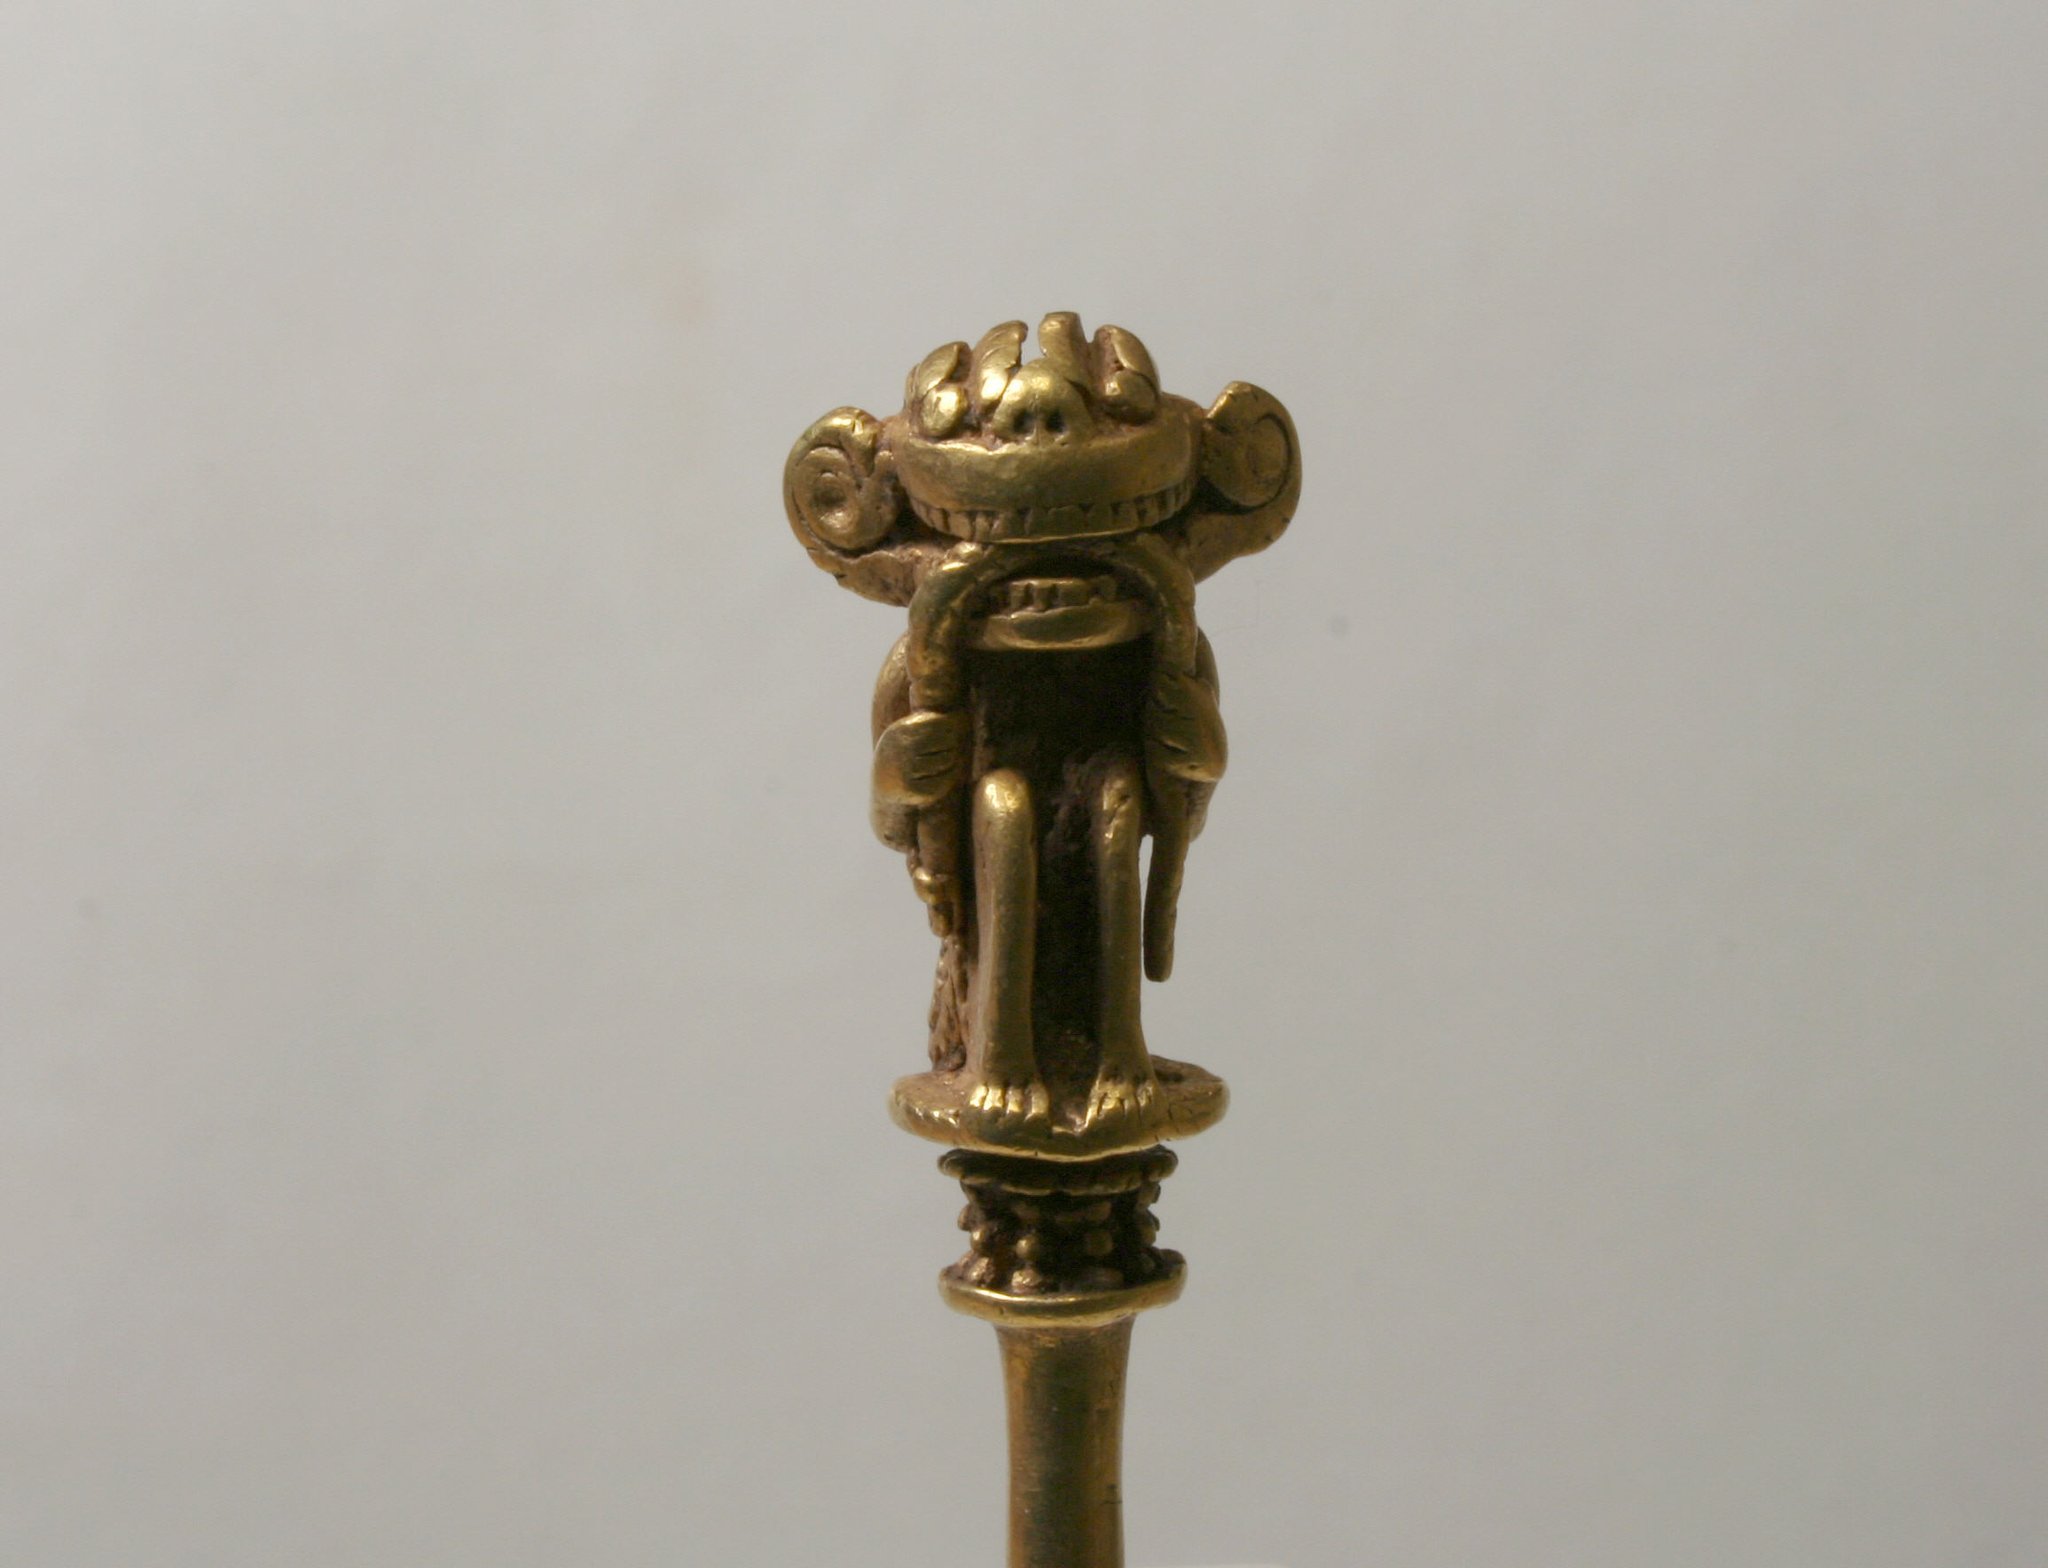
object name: lime dipper or pin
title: Lime Dipper or Pin, Monkey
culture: calima or yotoco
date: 1-700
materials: gold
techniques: casting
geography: colombia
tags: monkeys